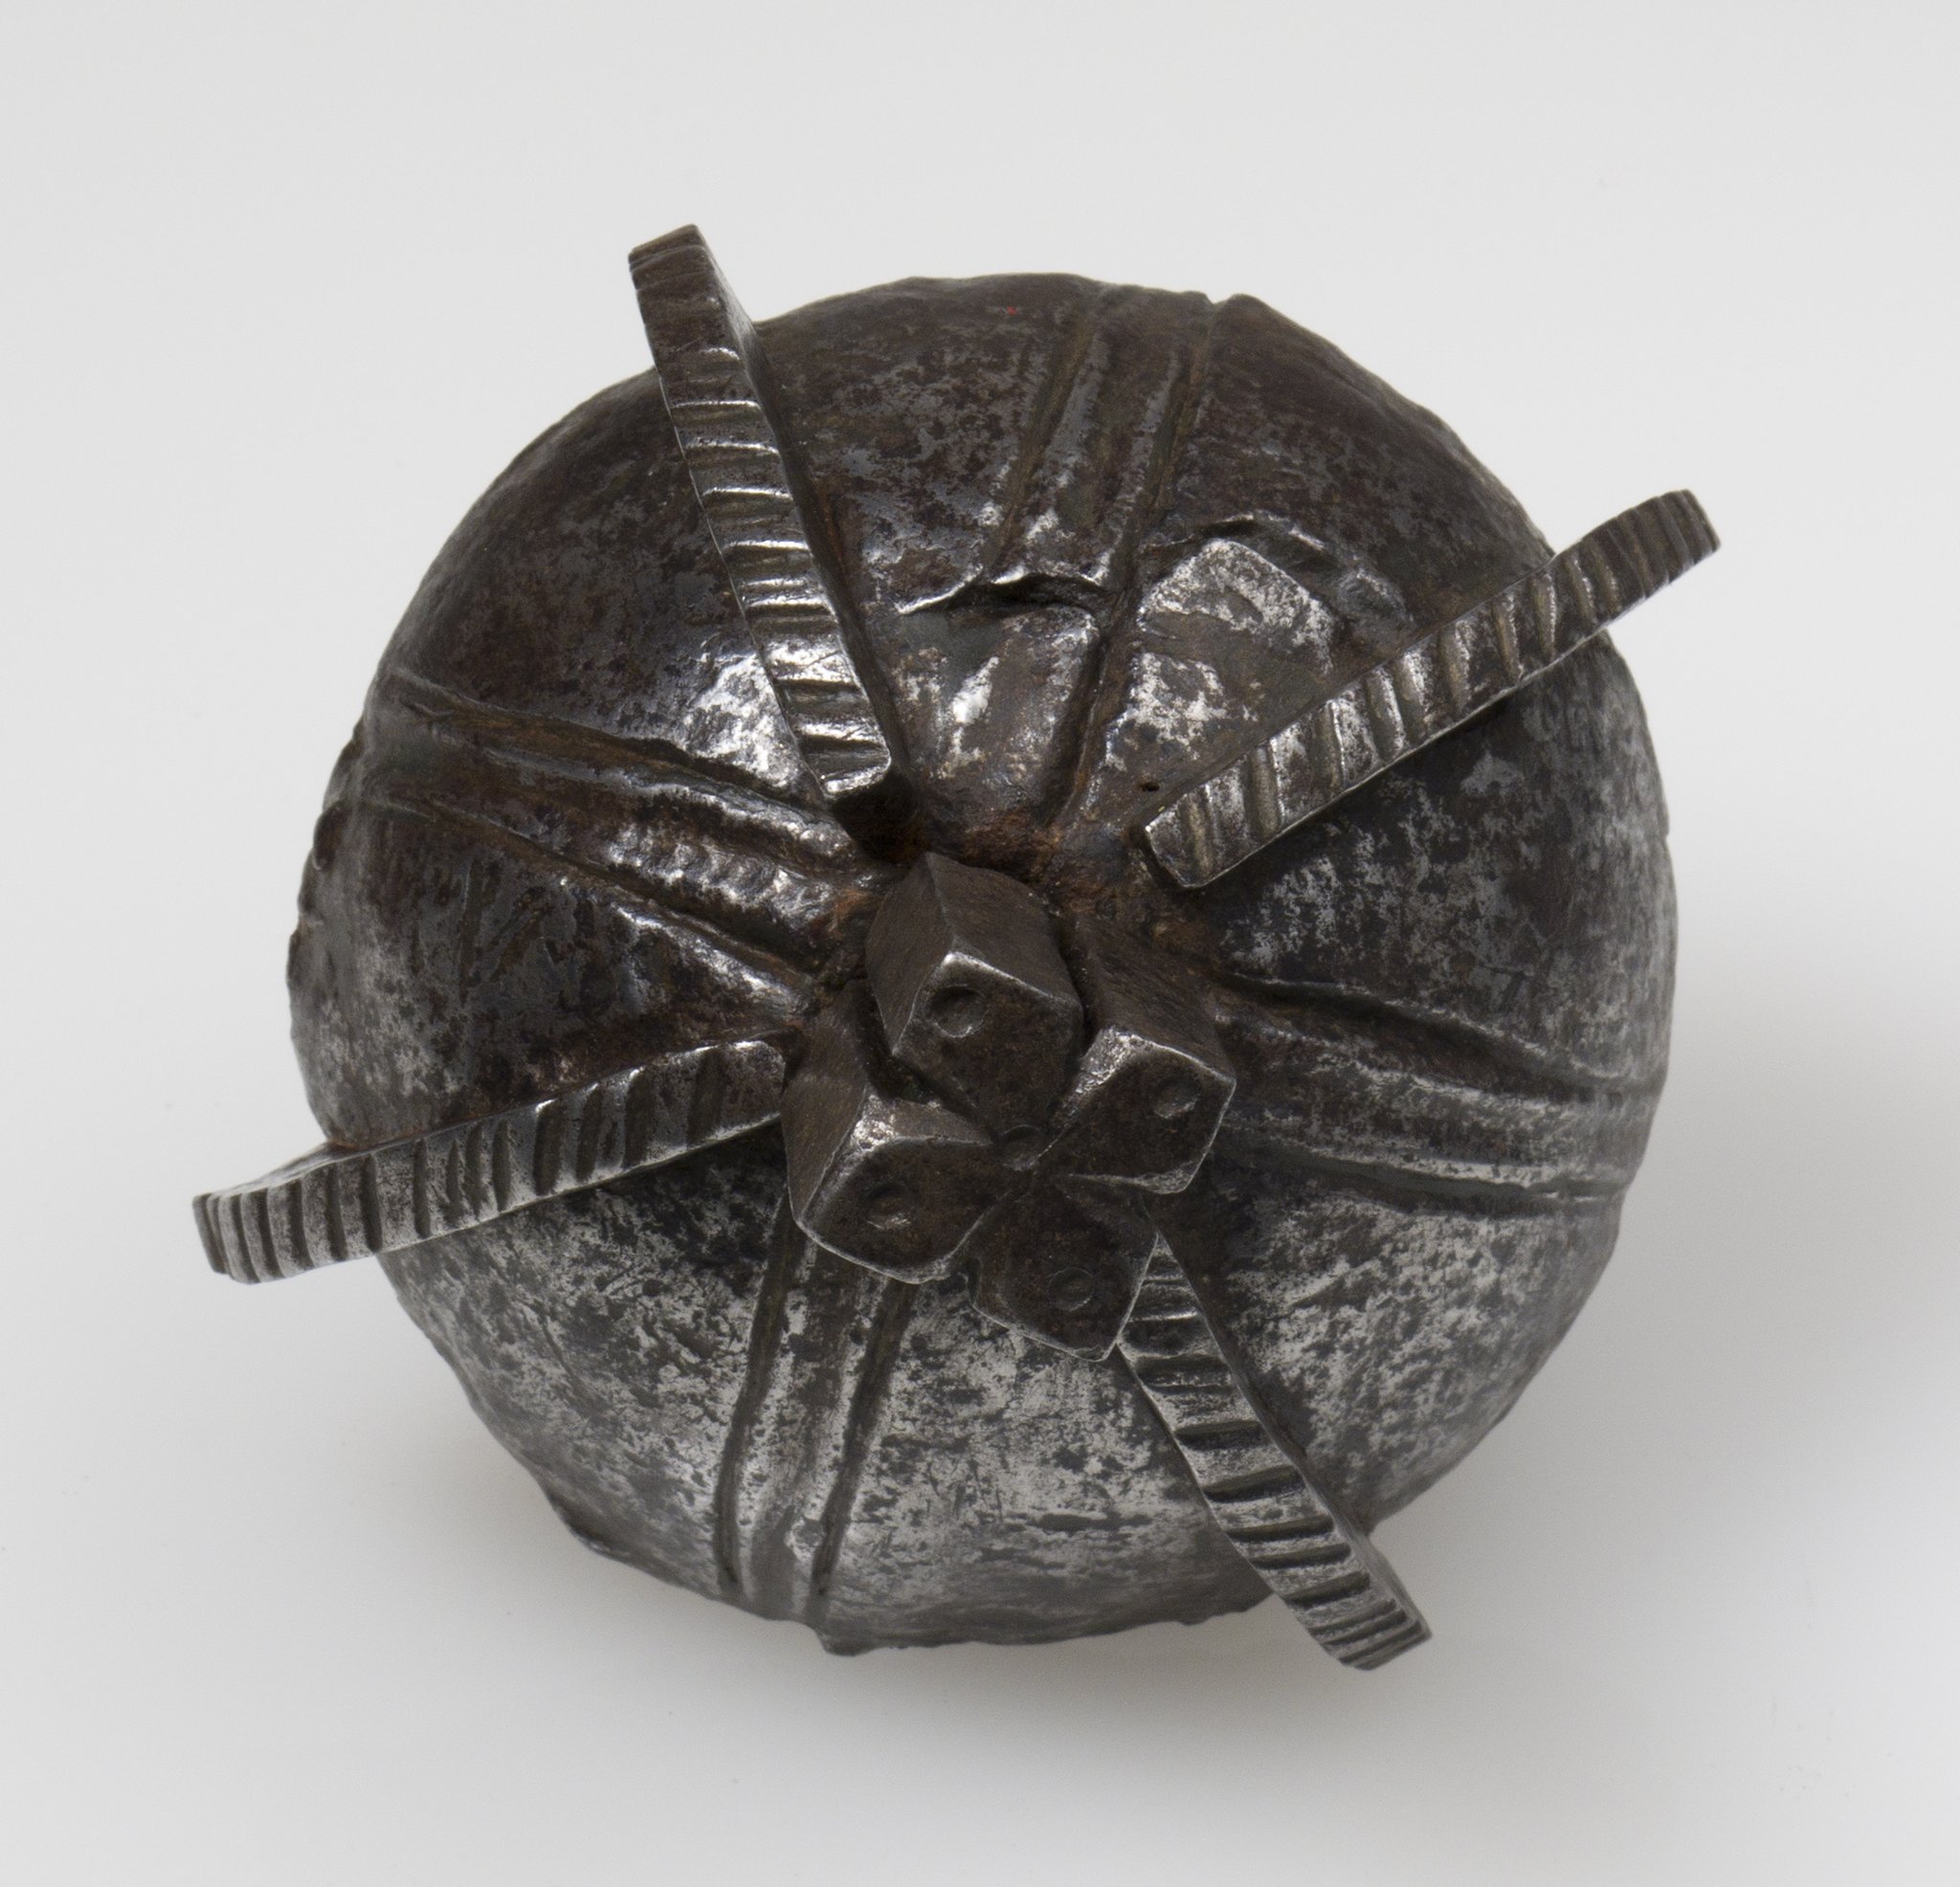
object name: bos and nail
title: Boss and Nail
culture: european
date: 1401-1600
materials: iron